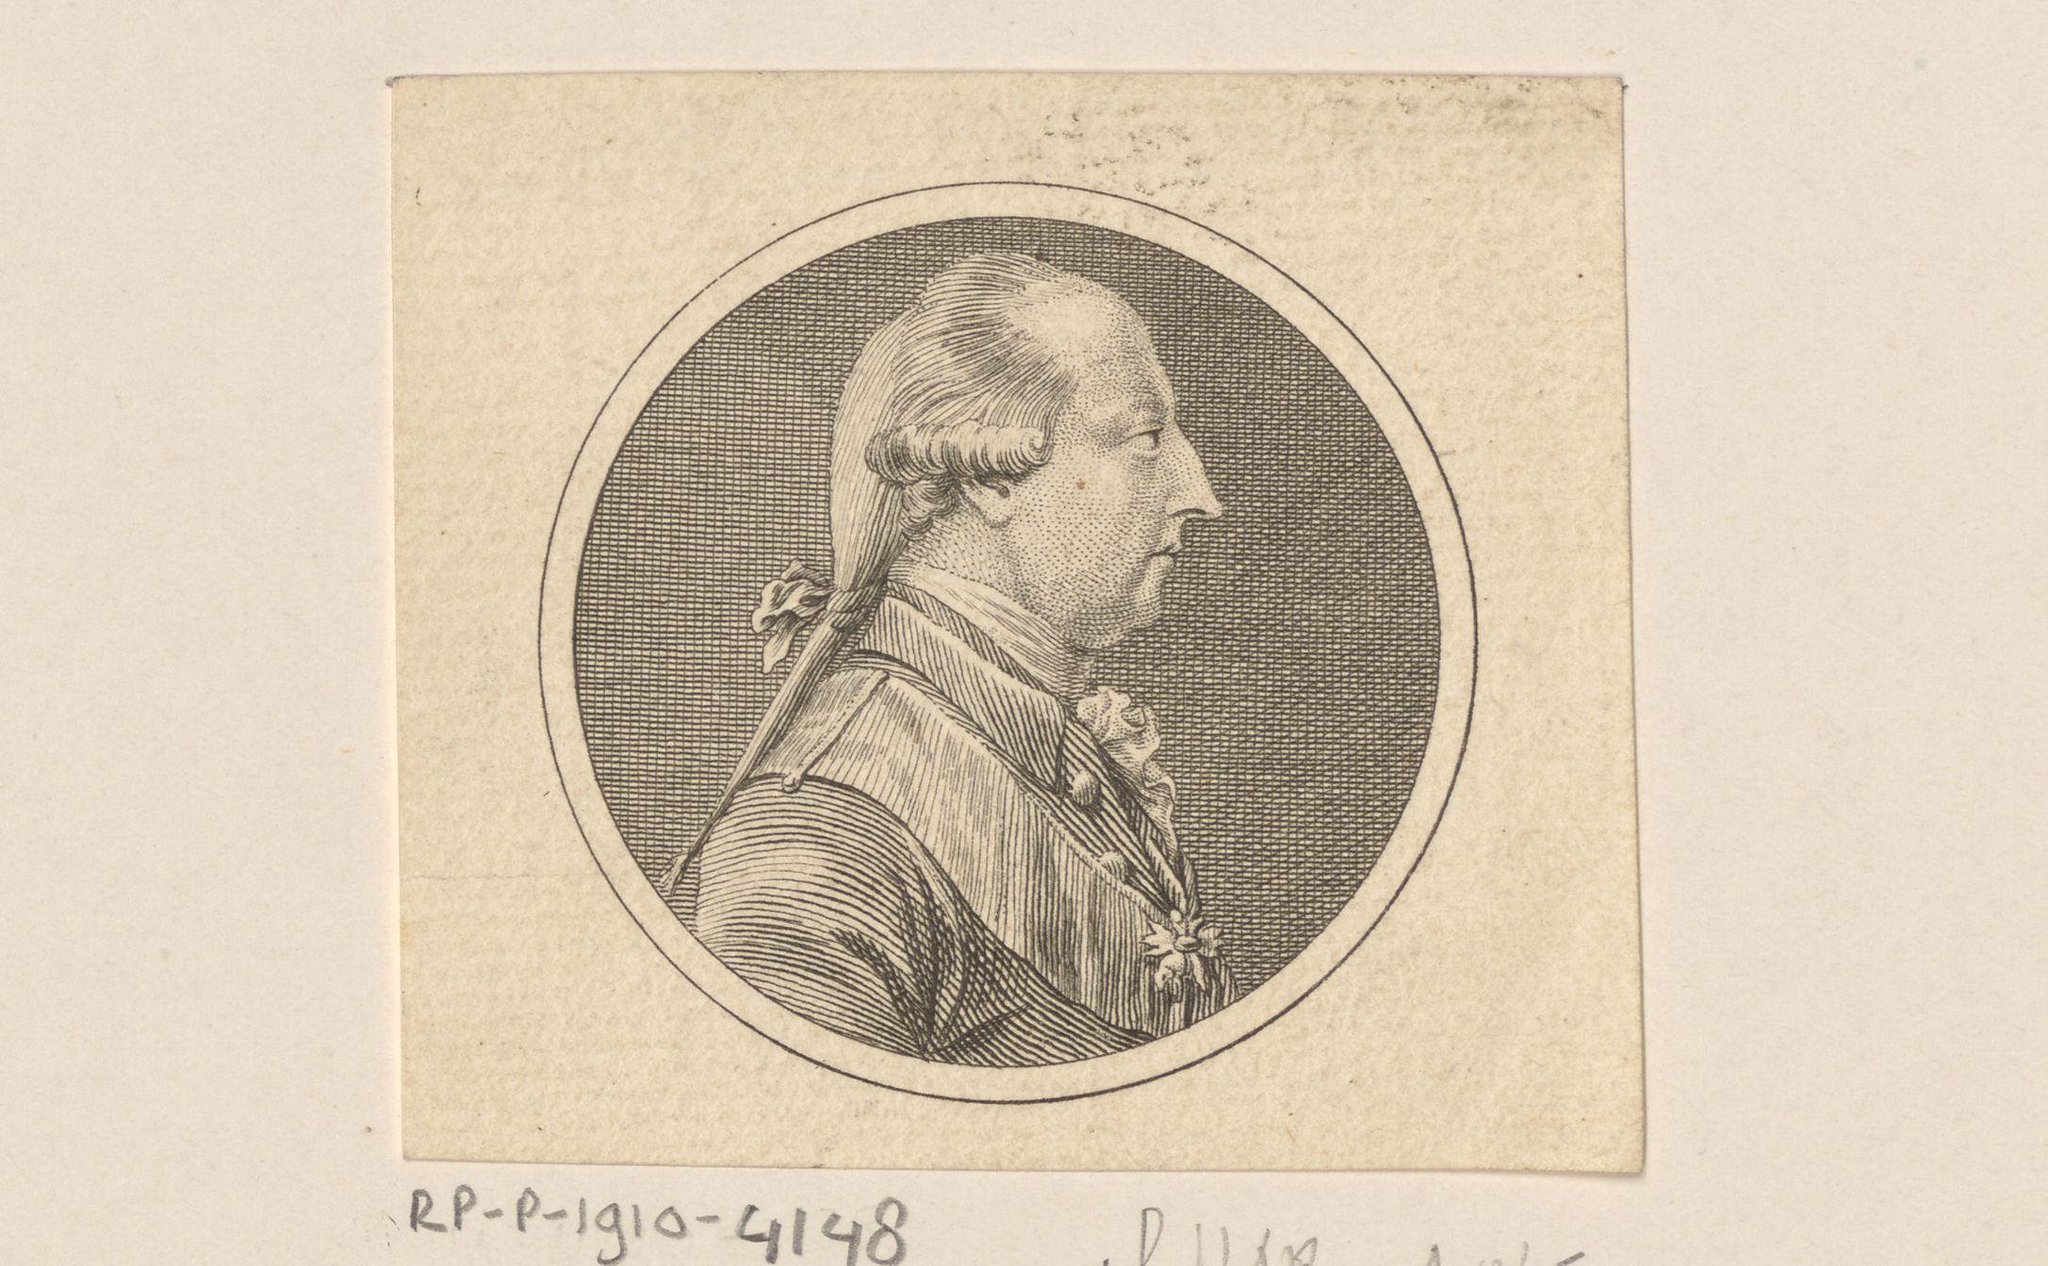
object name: print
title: Portret van Jozef II, Duits keizer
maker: Anonymous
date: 1765-1799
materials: paper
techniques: engraving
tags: jozef ii (duits keizer), historical persons, emperor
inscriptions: collector's mark: Lugt 2228